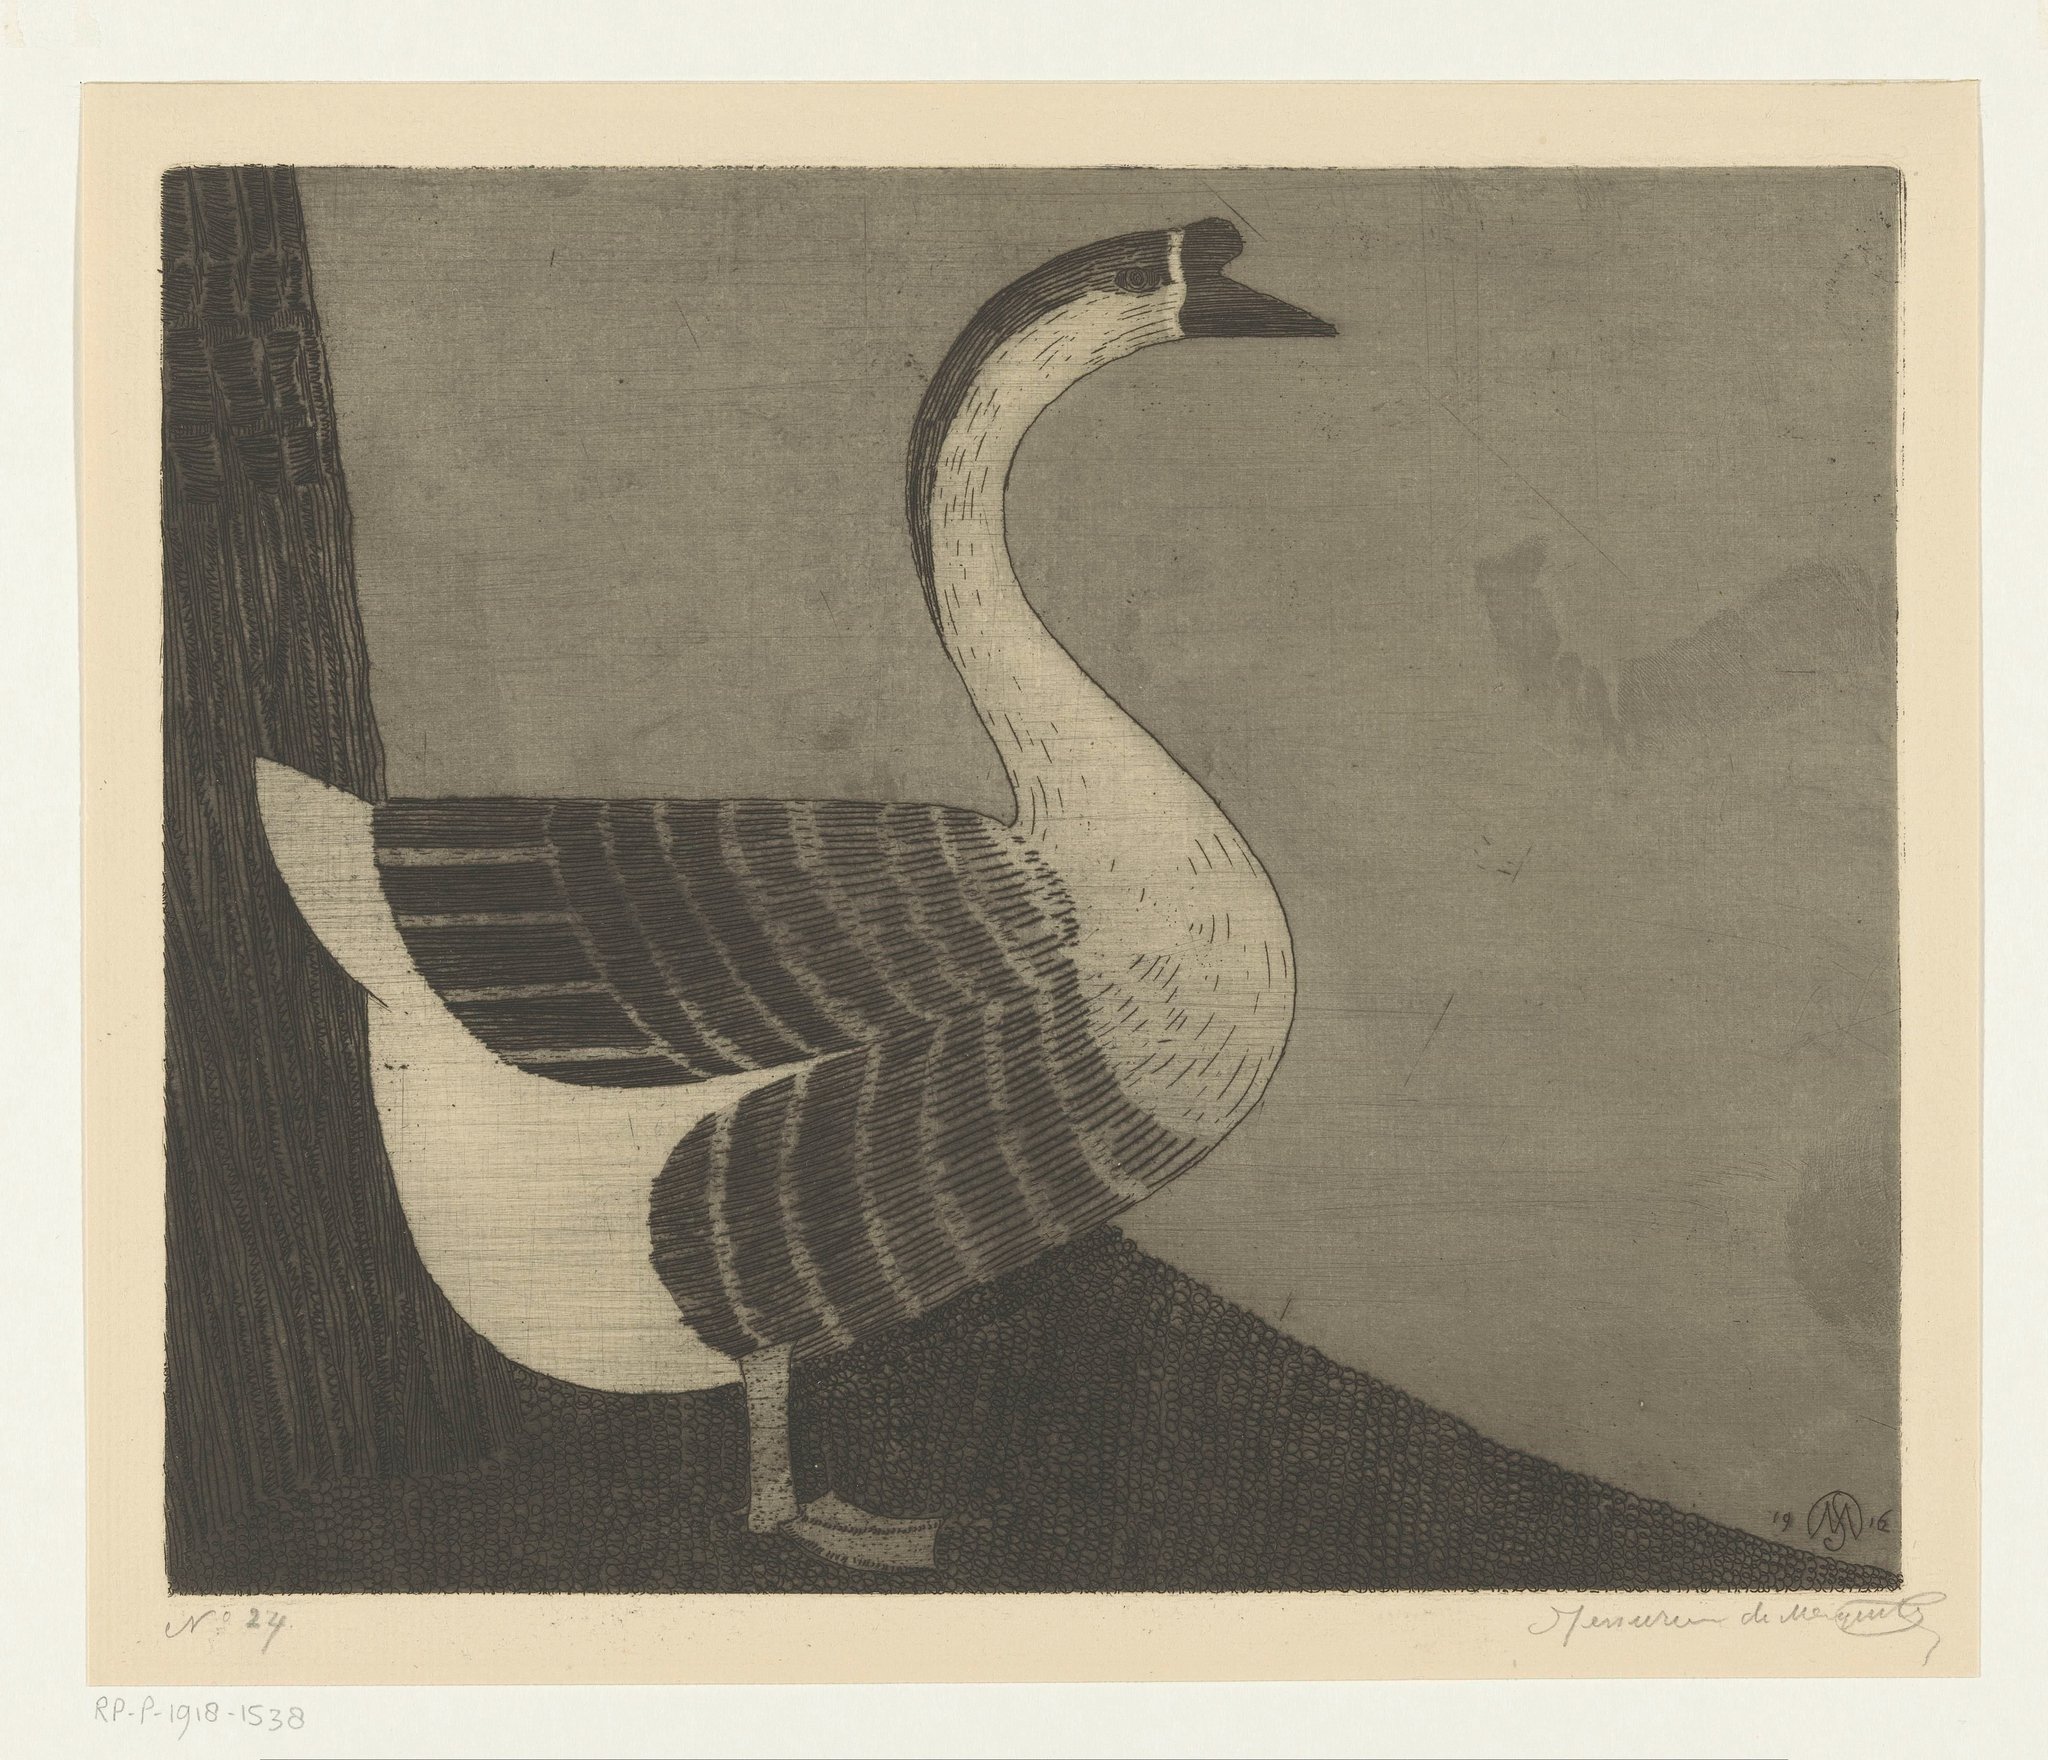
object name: print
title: Knobbelgans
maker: samuel jessurun de mesquita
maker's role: draughtsman, print maker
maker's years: 1868-1944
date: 1916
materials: paper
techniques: aquatint, etching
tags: geese (domestic waterbirds)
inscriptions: collector's mark: Lugt 733, collector's mark: Lugt 2228, number: ‘No 24’